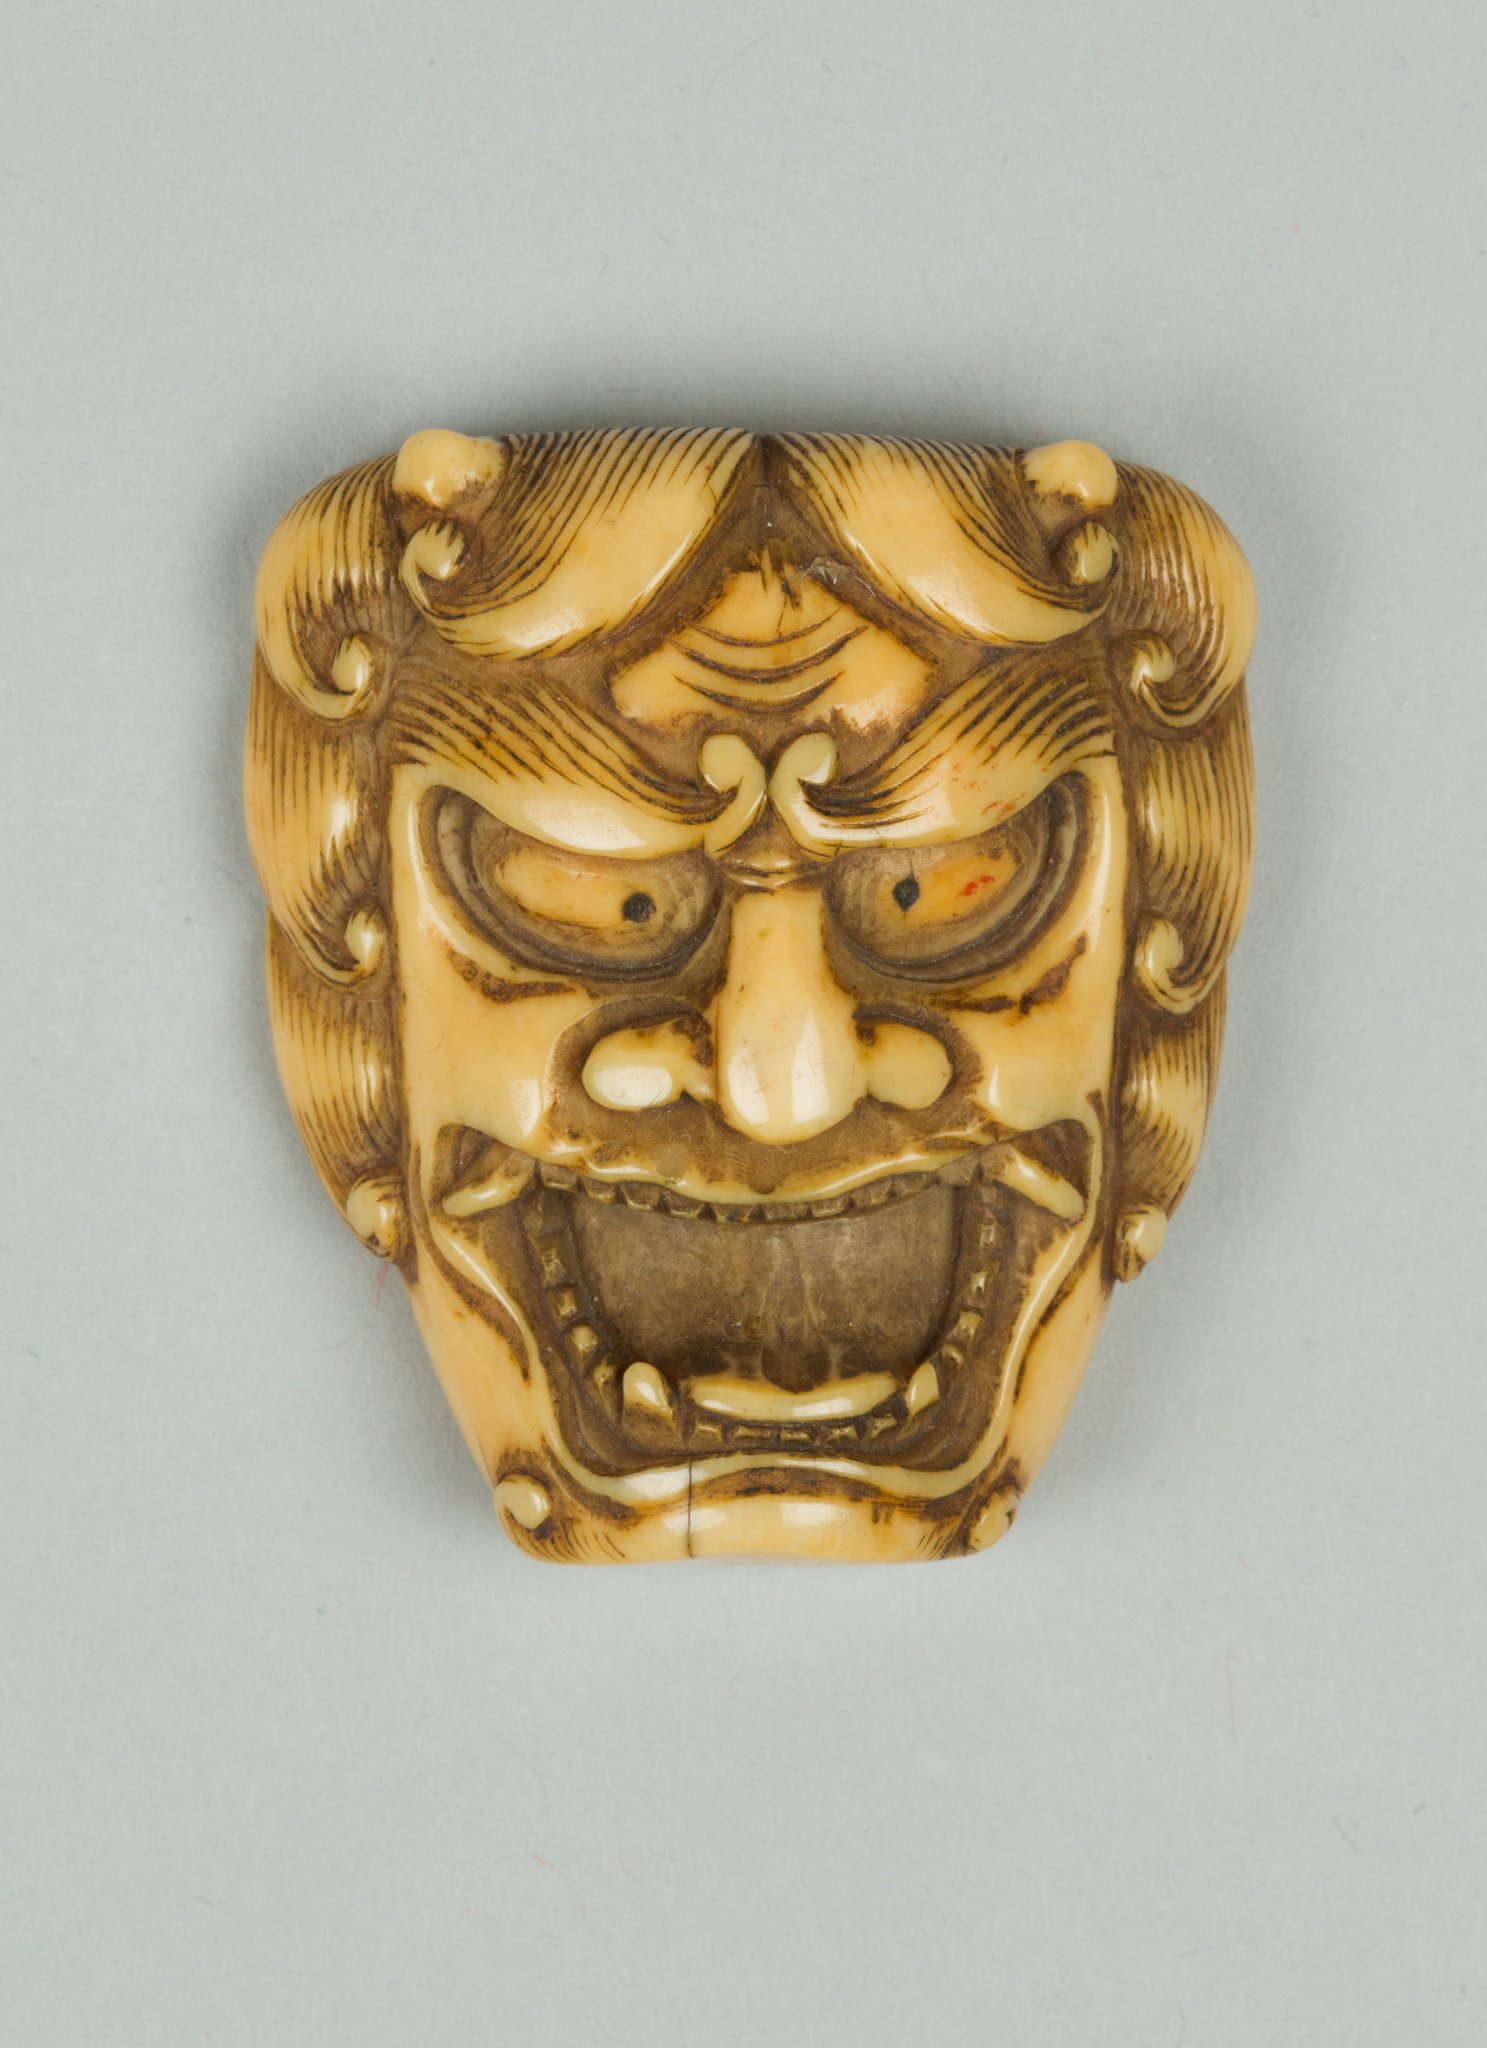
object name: netsuke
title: Netsuke of Mask of a Man with Open Mouth and Curly Hair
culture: japanese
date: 1801-1900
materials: ivory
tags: masks